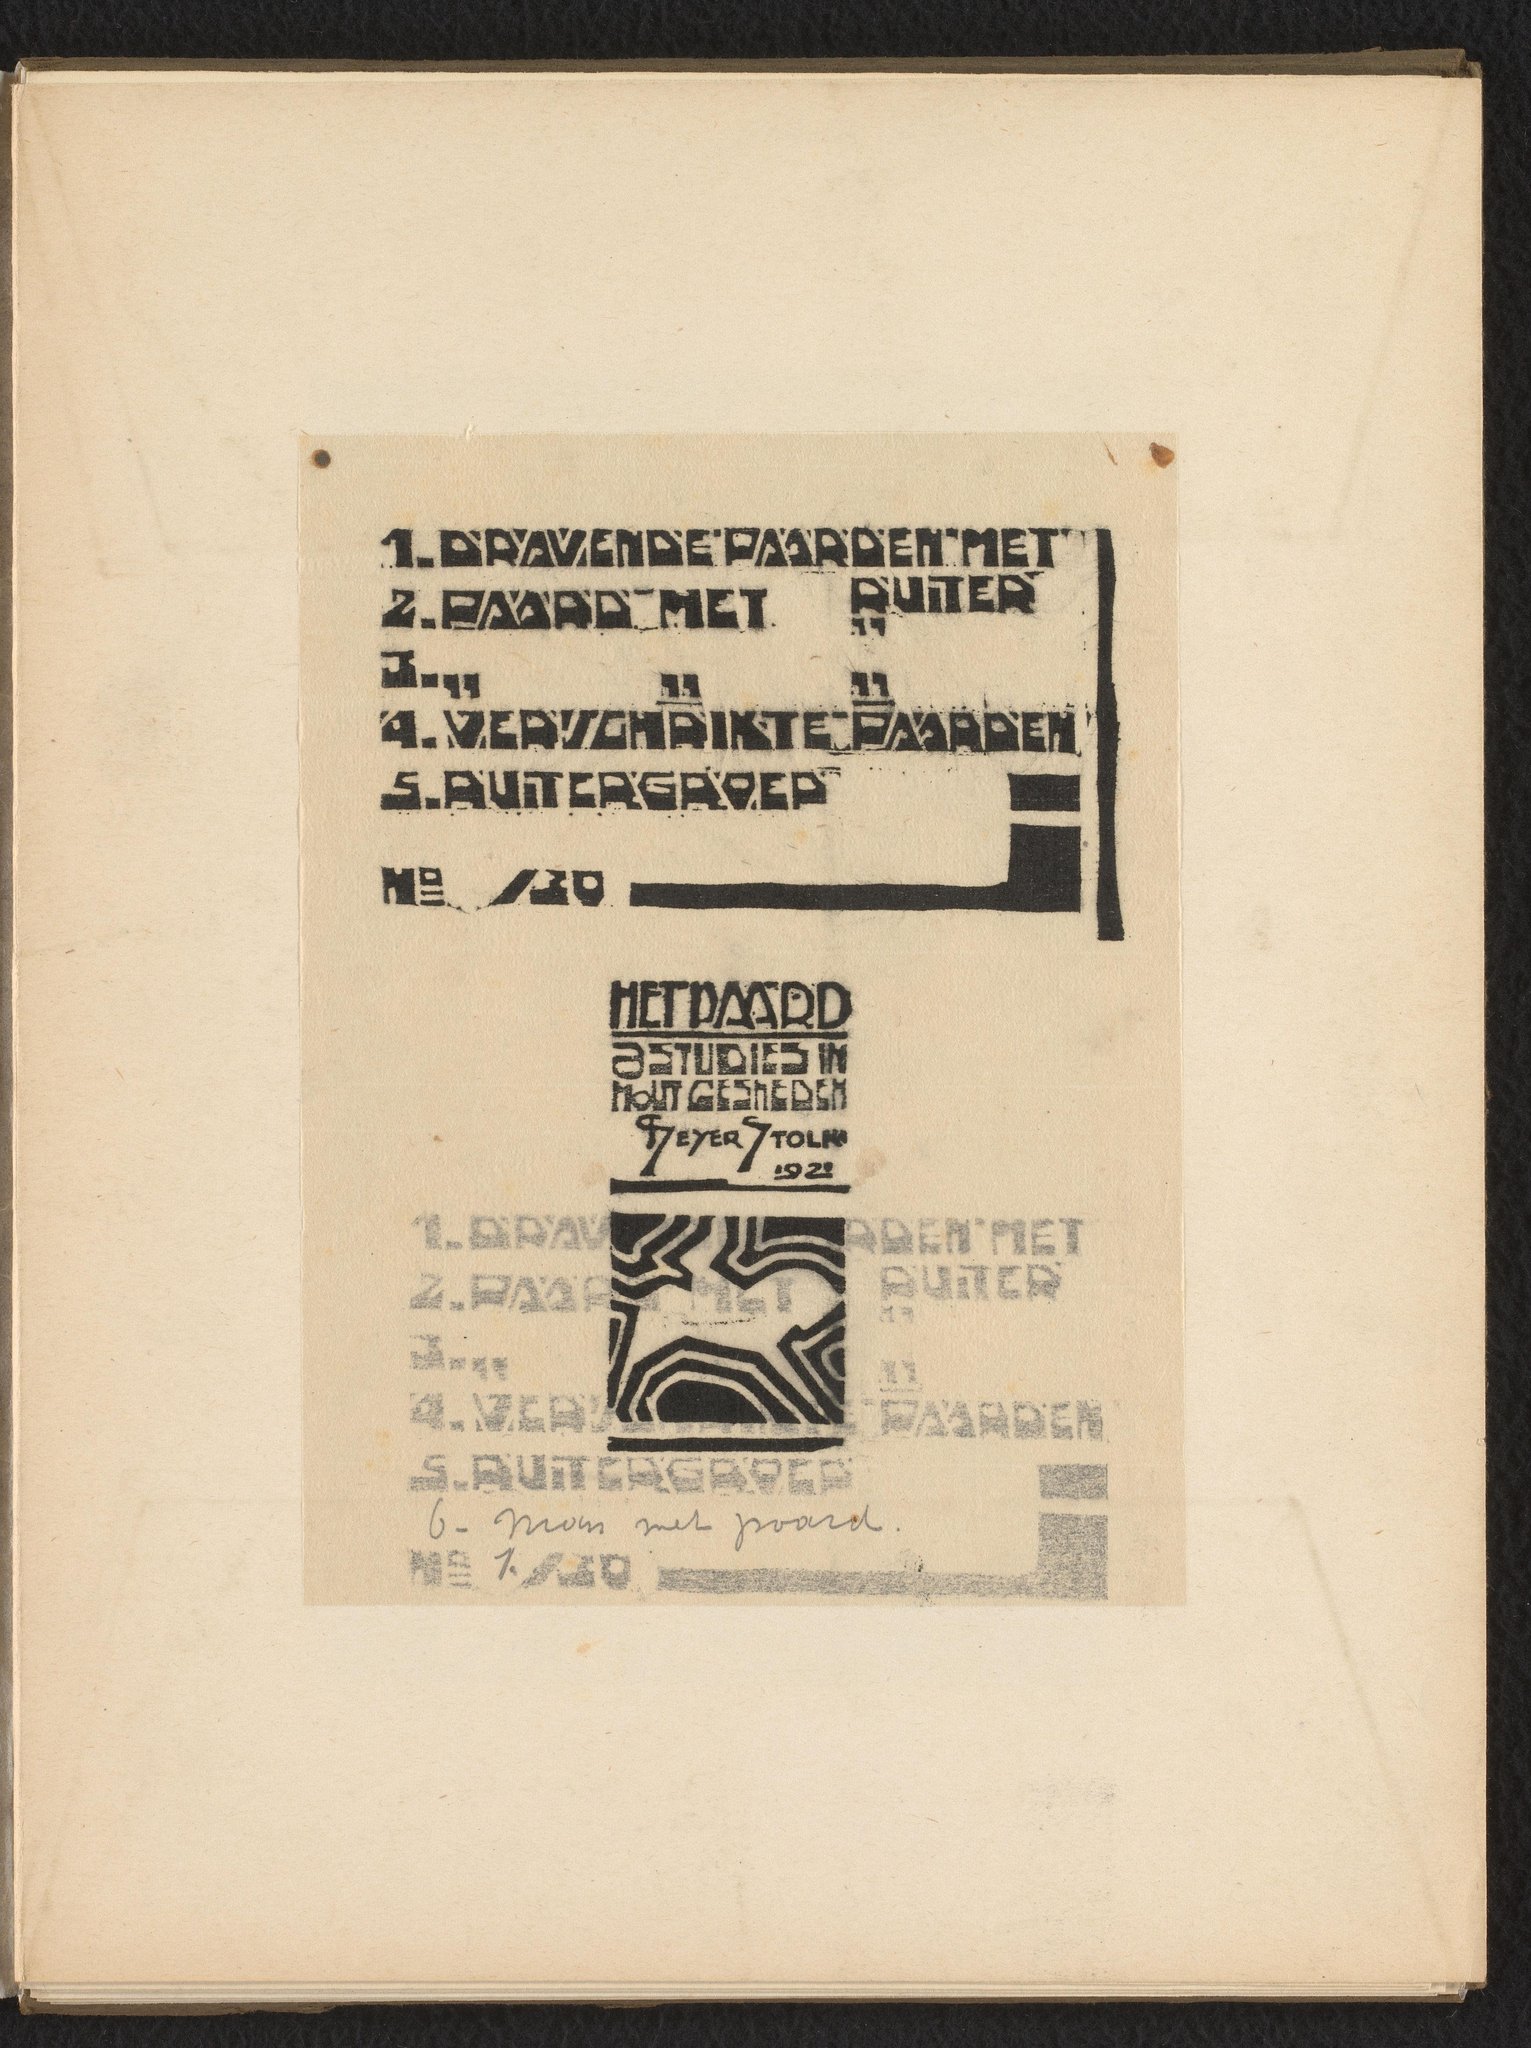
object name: print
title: Het paard, 6 studies in hout gesneden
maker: reijer stolk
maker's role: draughtsman, print maker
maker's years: 1896-1945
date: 1920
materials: paper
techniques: woodcut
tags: horse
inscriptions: collector's mark: Lugt 2228, collector's mark: Lugt 2760